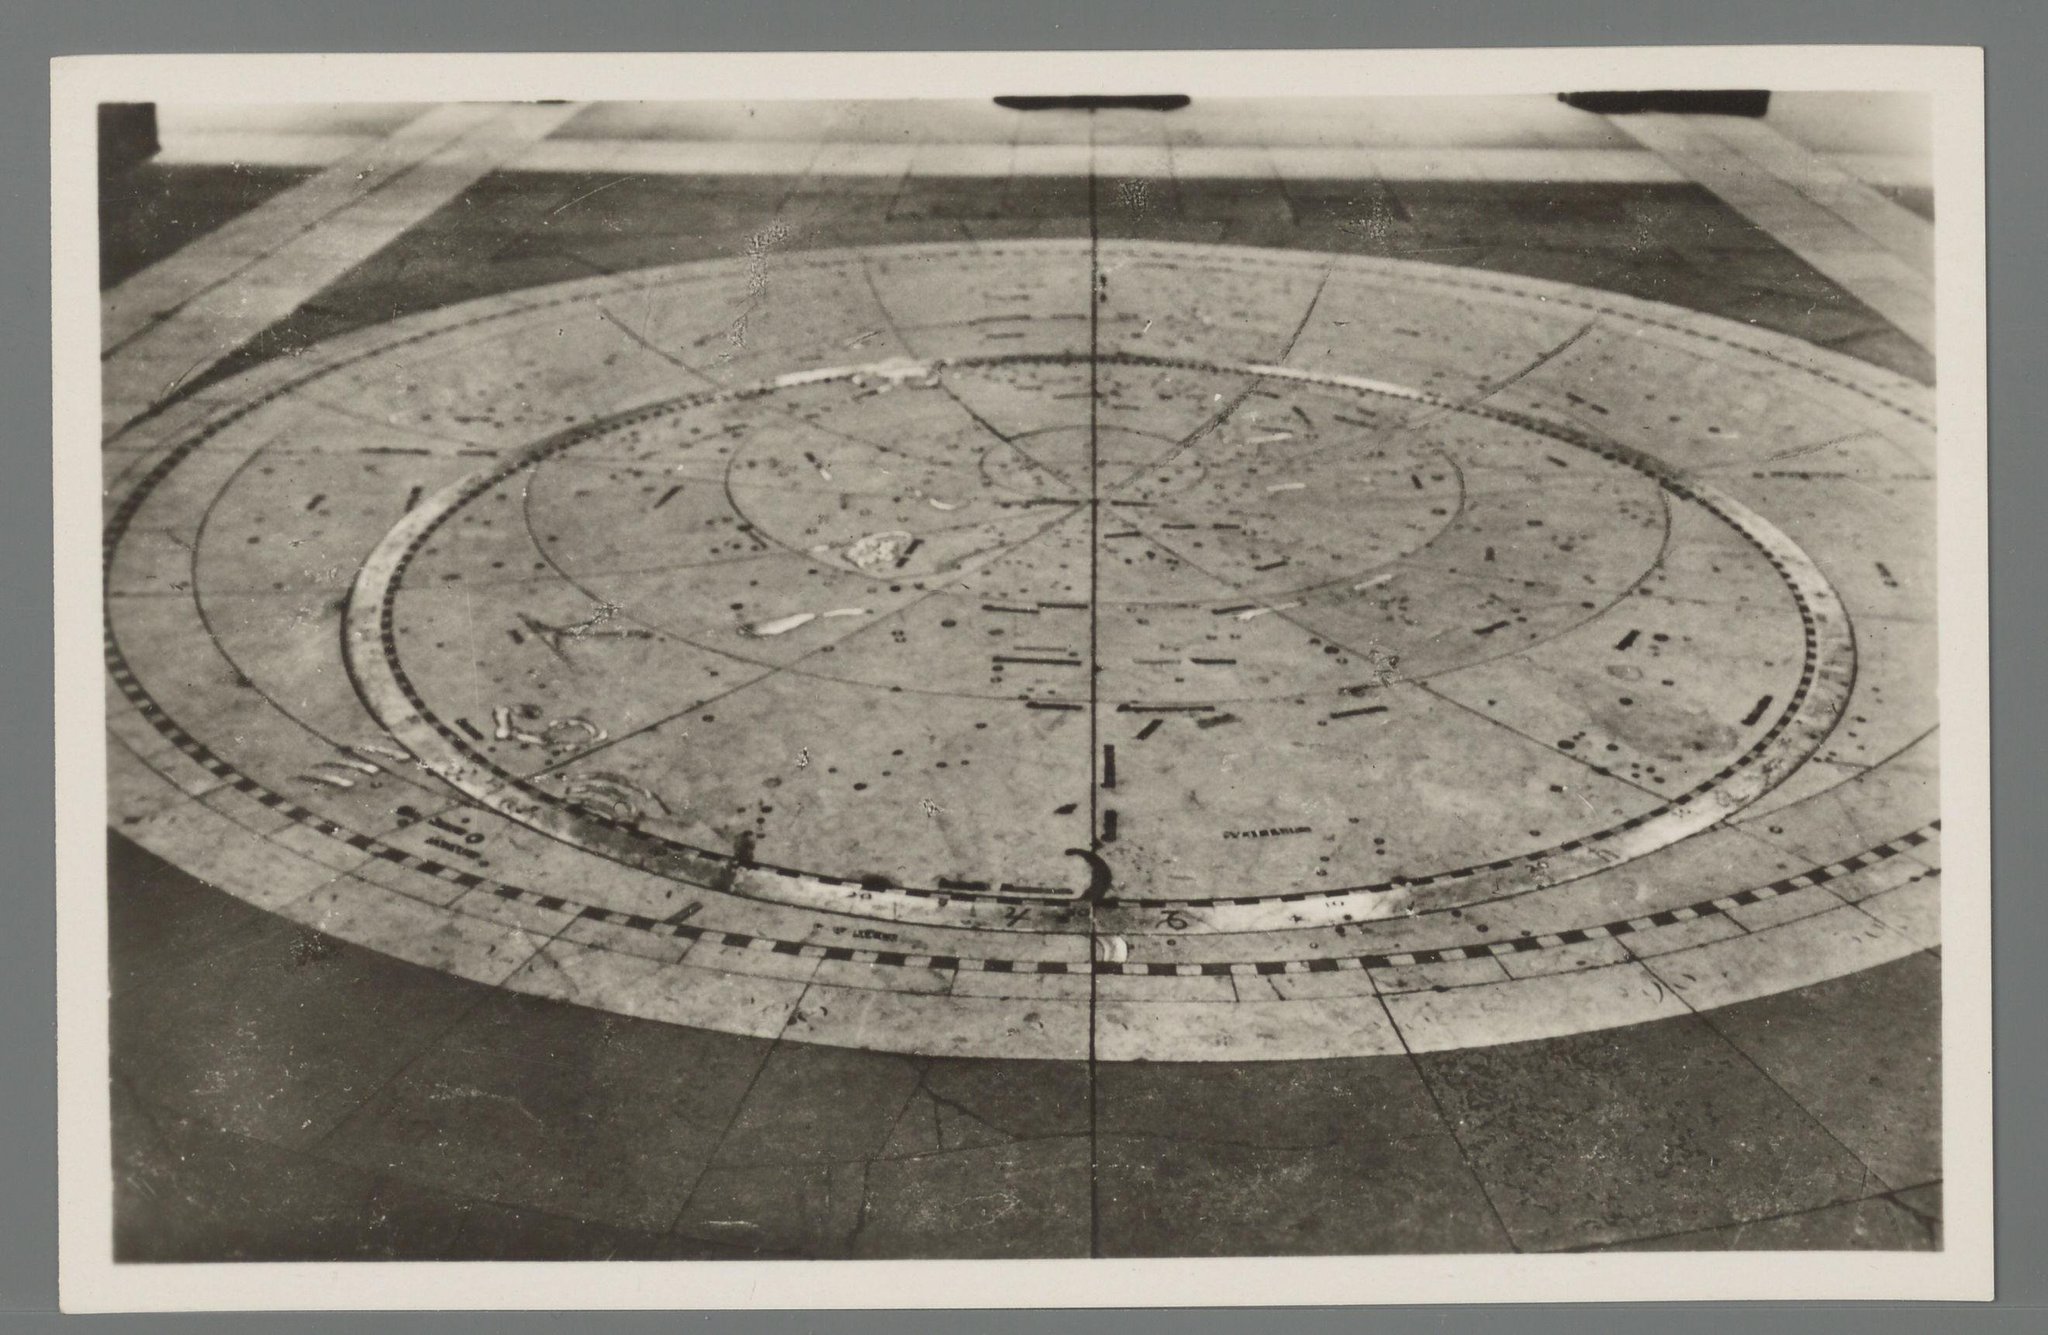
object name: photograph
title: Koninklijk Paleis Amsterdam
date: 1932-1947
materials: photographic support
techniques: photography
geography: the hague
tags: palace - aa - civic architecture: inside, decorations (interior of the house), pavement, floor ~ architecture, royal palace of amsterdam